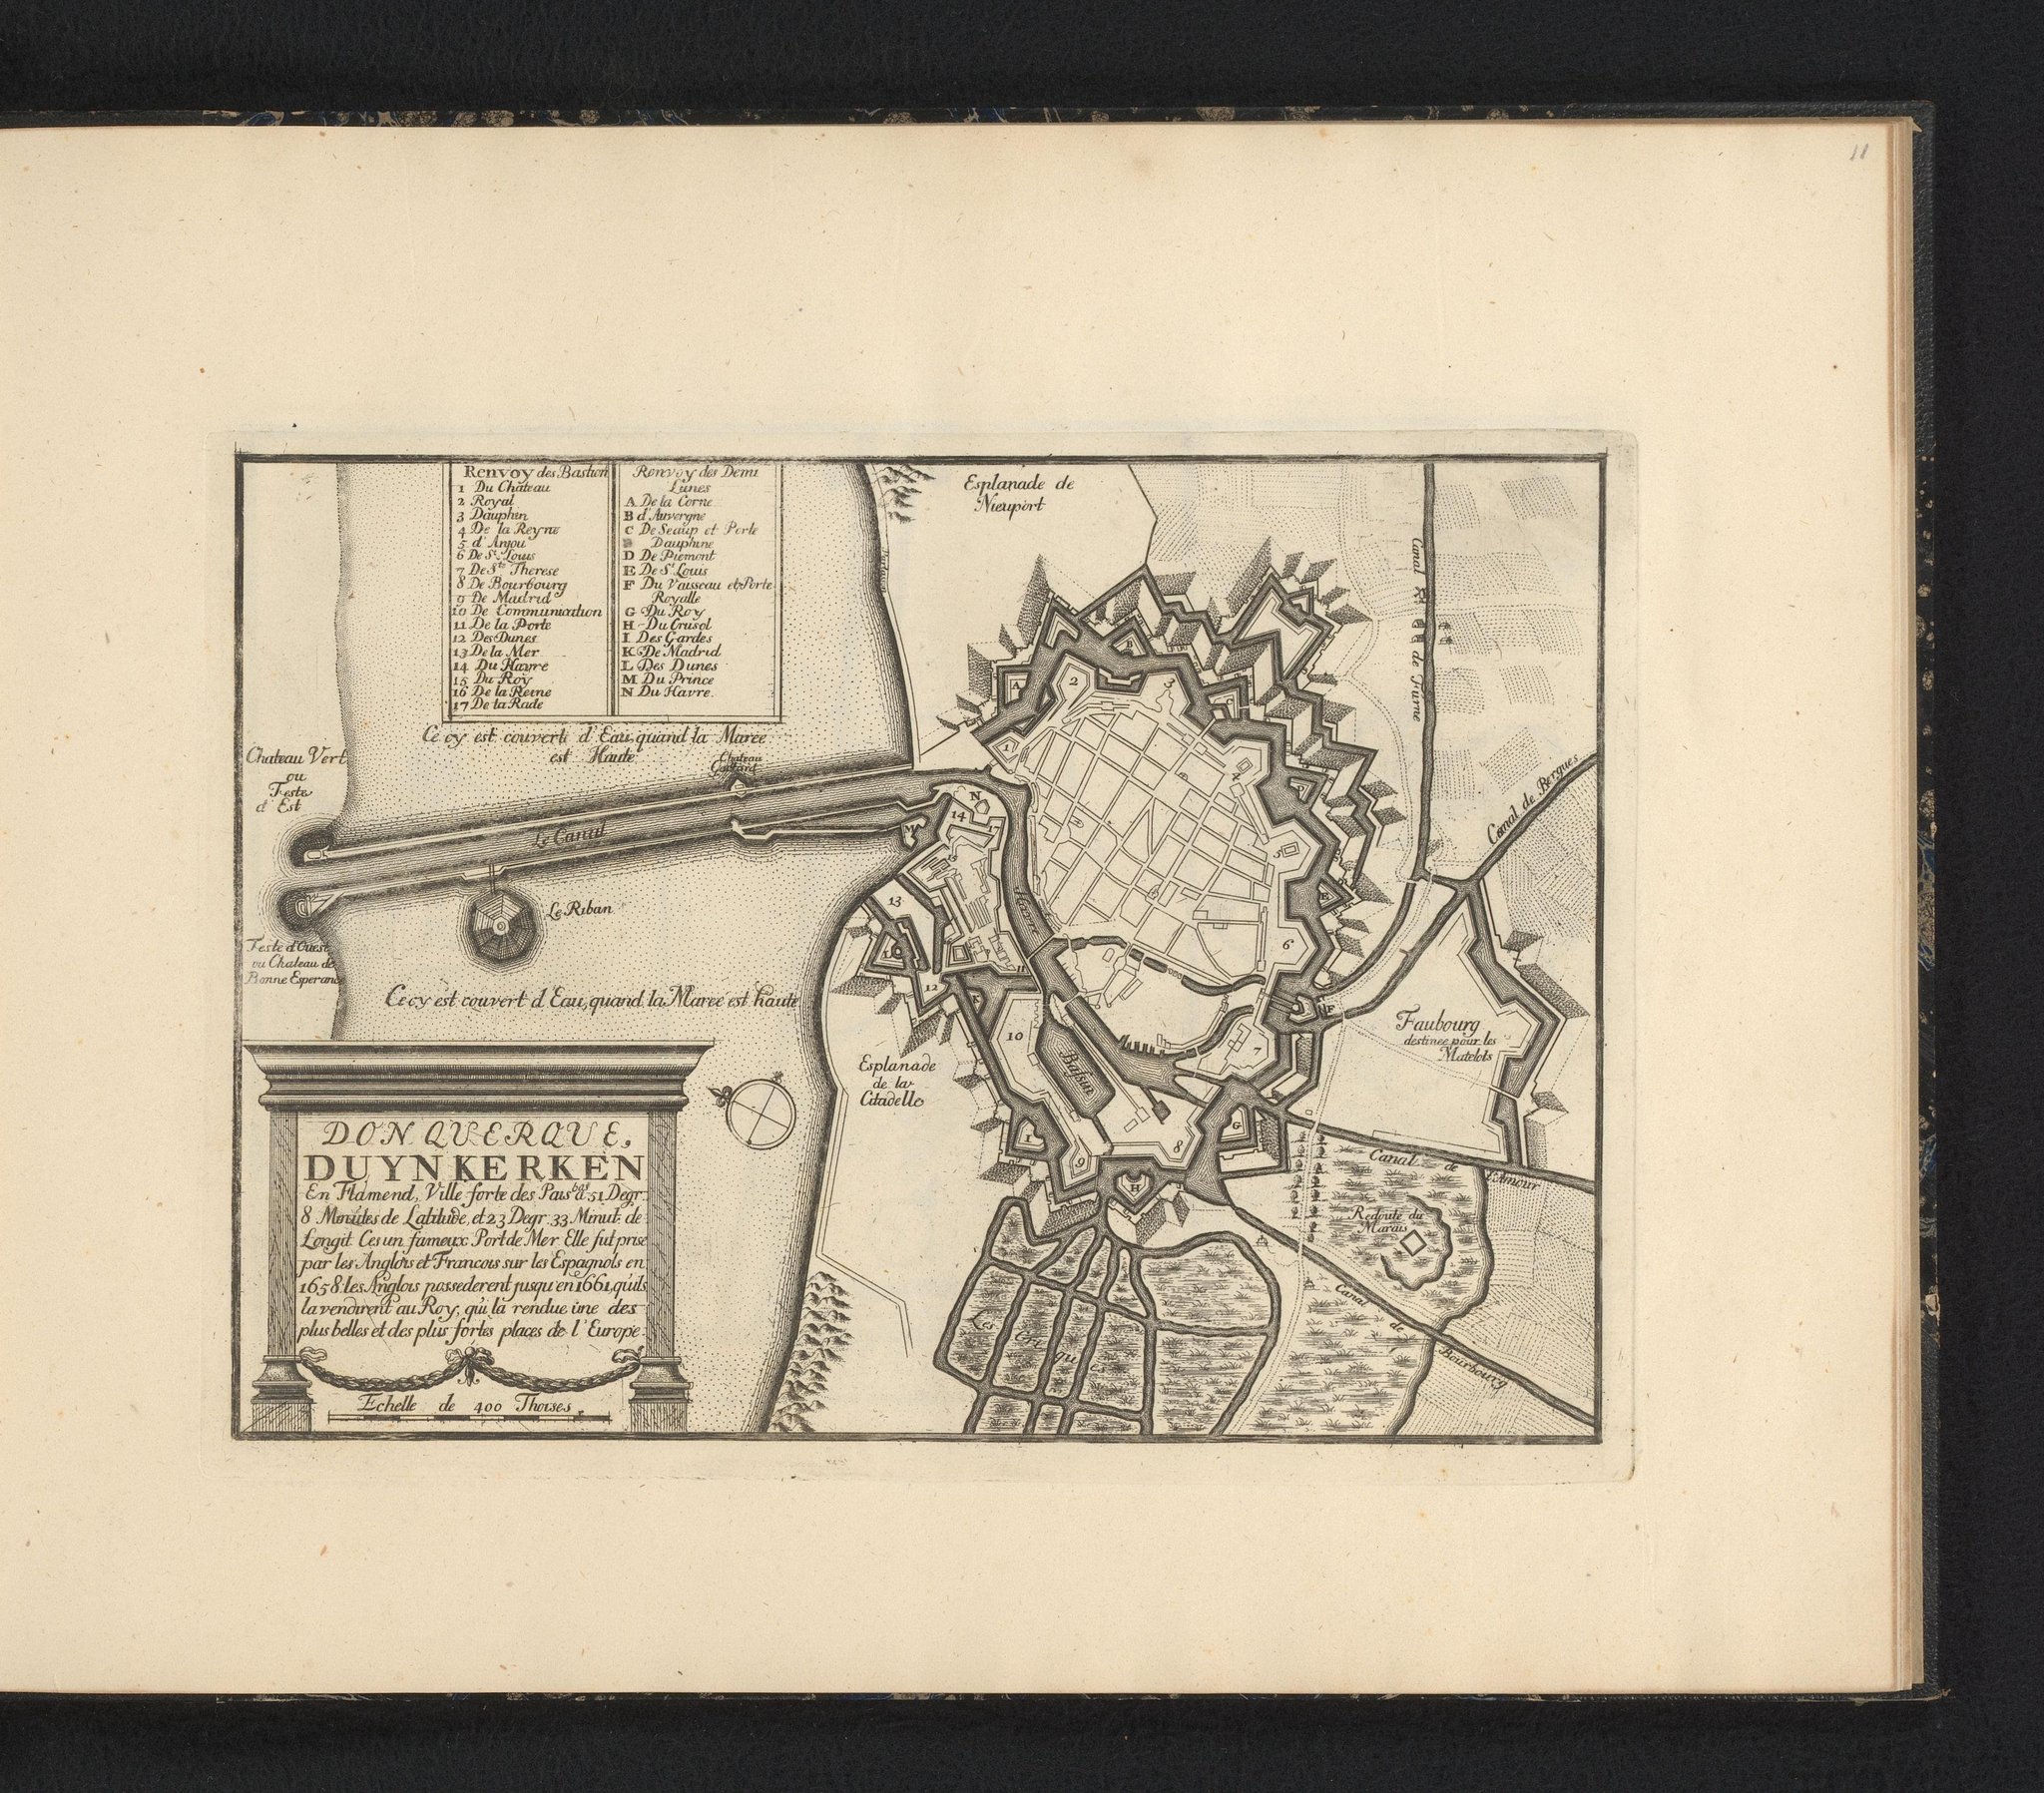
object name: print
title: Donquerque, Duynkerken en Flamand Ville Forte des Pais Bas (...)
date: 1693-1696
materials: paper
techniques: etching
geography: paris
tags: fortress, maps of cities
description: Plattegrond van de versterkingen om de Vlaamse stad Duinkerke. Maakt deel uit van het eerste deel van het prentwerk: Le Theatre de la Guerre, dans les Pays-Bas, uitgegeven in 1696. Dit deel bevat 25 platen met plannen (afkomstig van Sébastien Le Prestre, Seigneur de Vauban) van vermaarde sterke steden en vestingen in de Negenjarige Oorlog in de Nederlanden. Titel en opschriften in het Frans.